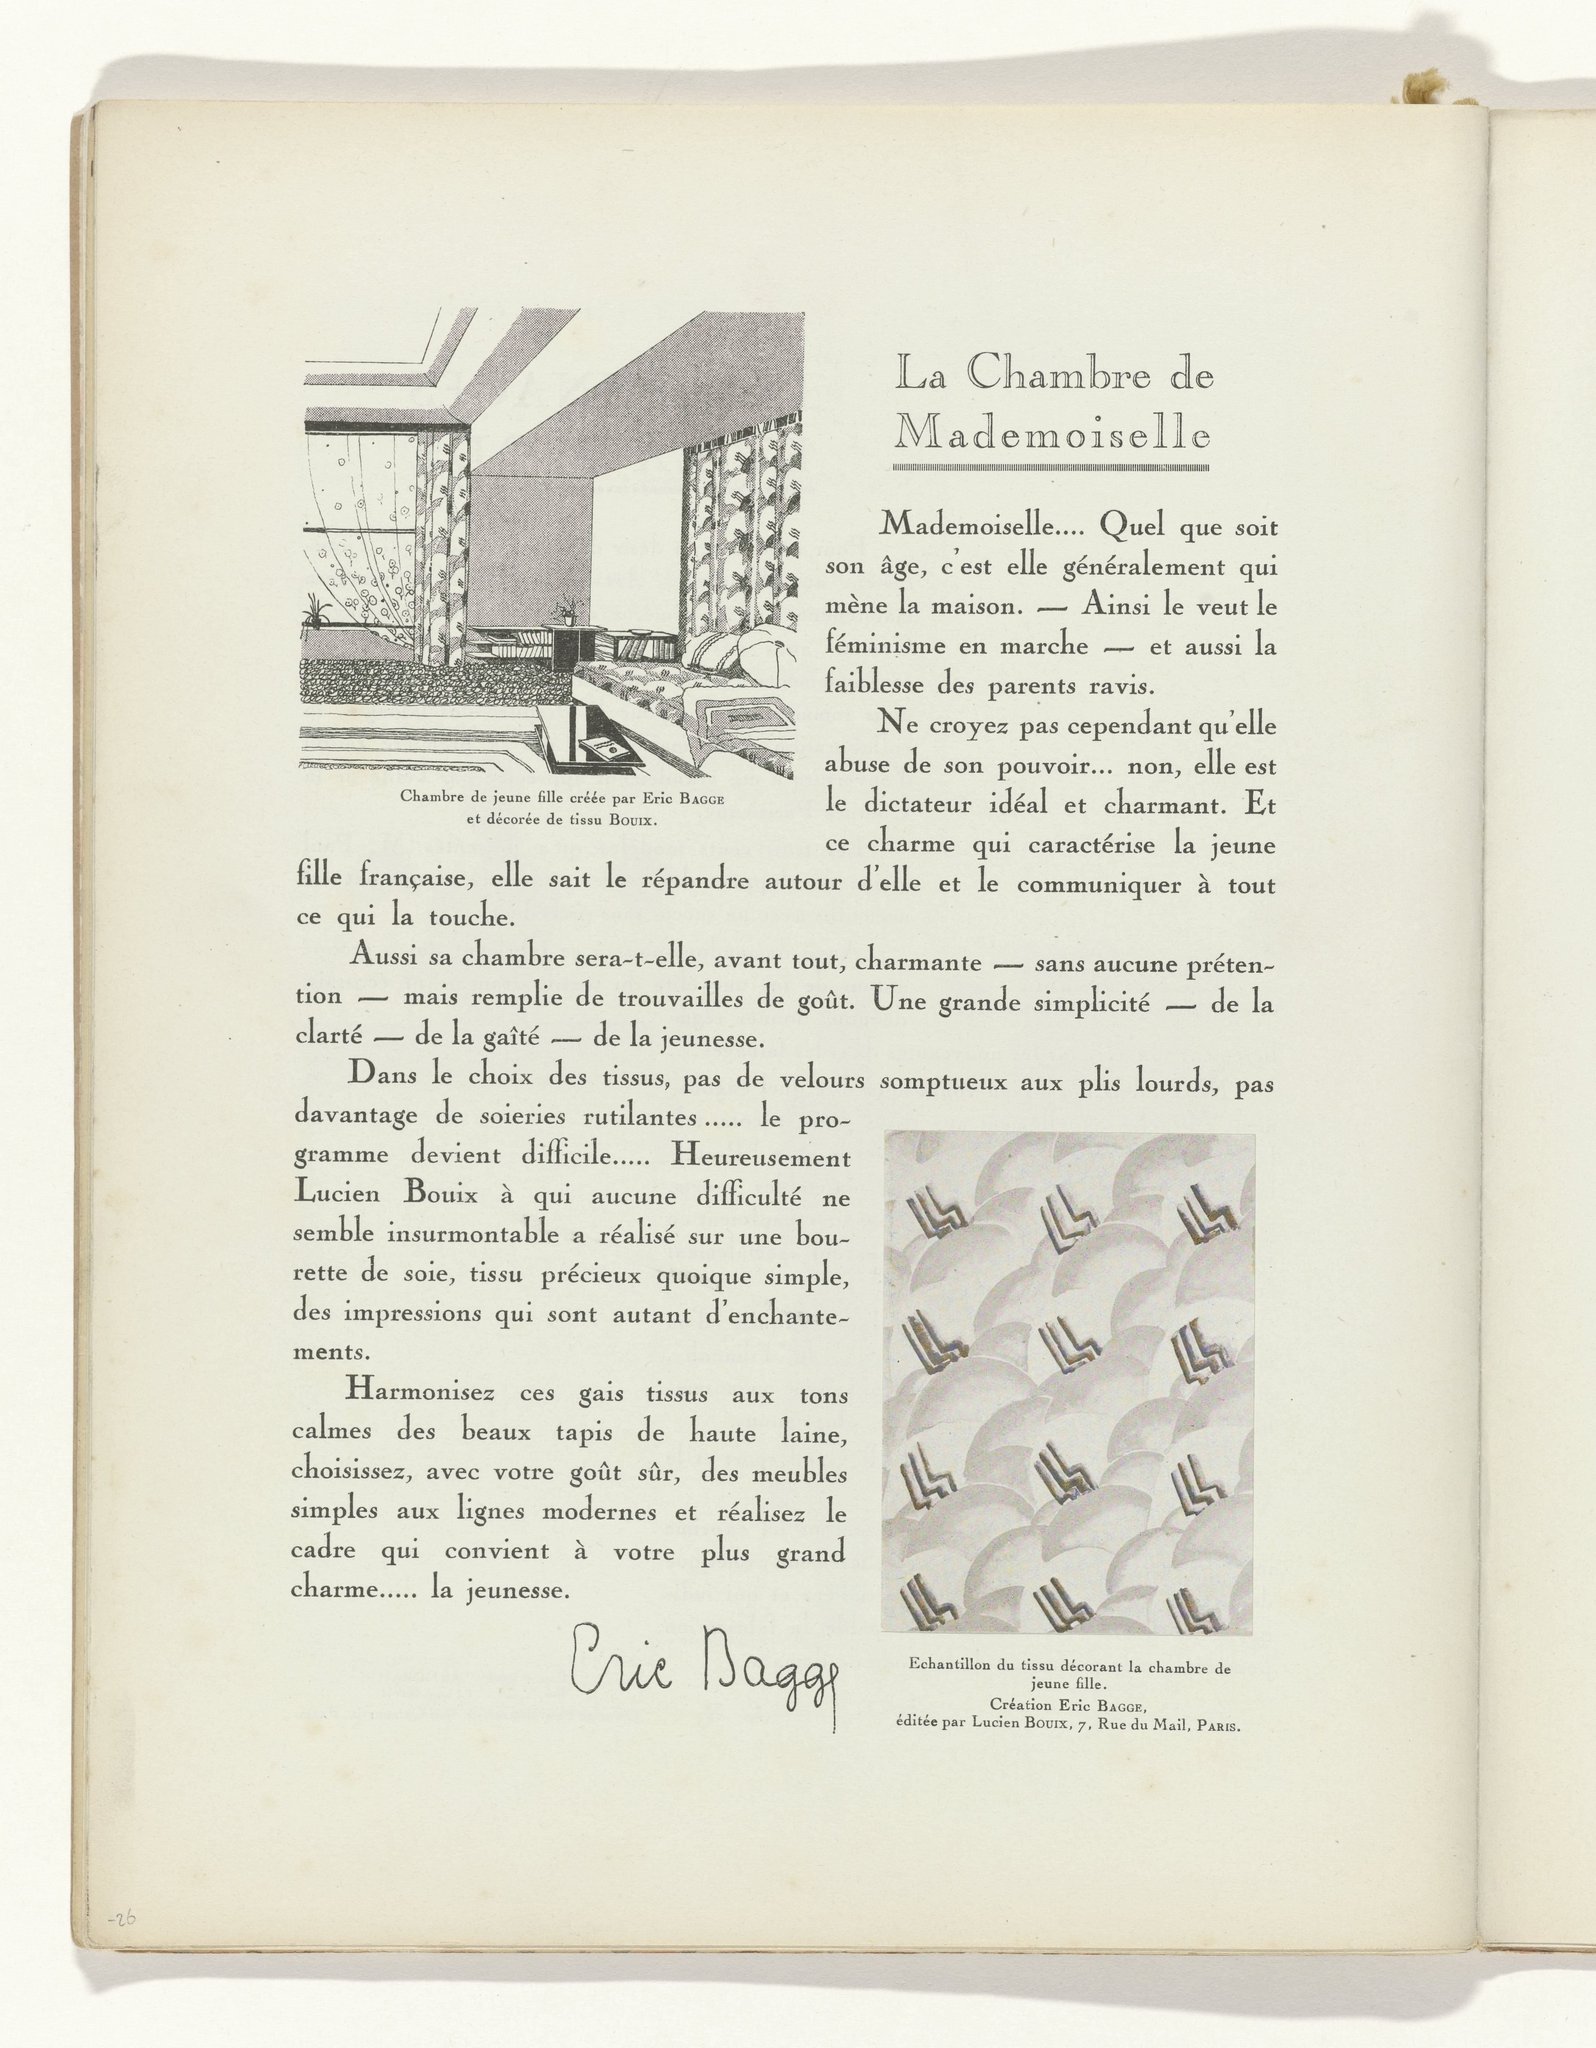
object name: magazine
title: Art - Goût - Beauté, Feuillets de l' élégance féminine, Mai 1929, No. 105, 9e Année, p. 27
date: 1929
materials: paper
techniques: lithograph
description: La Chambre de Mademoiselle. Pagina uit het modetijdschrift Art-Goût-Beauté (1920-1933).